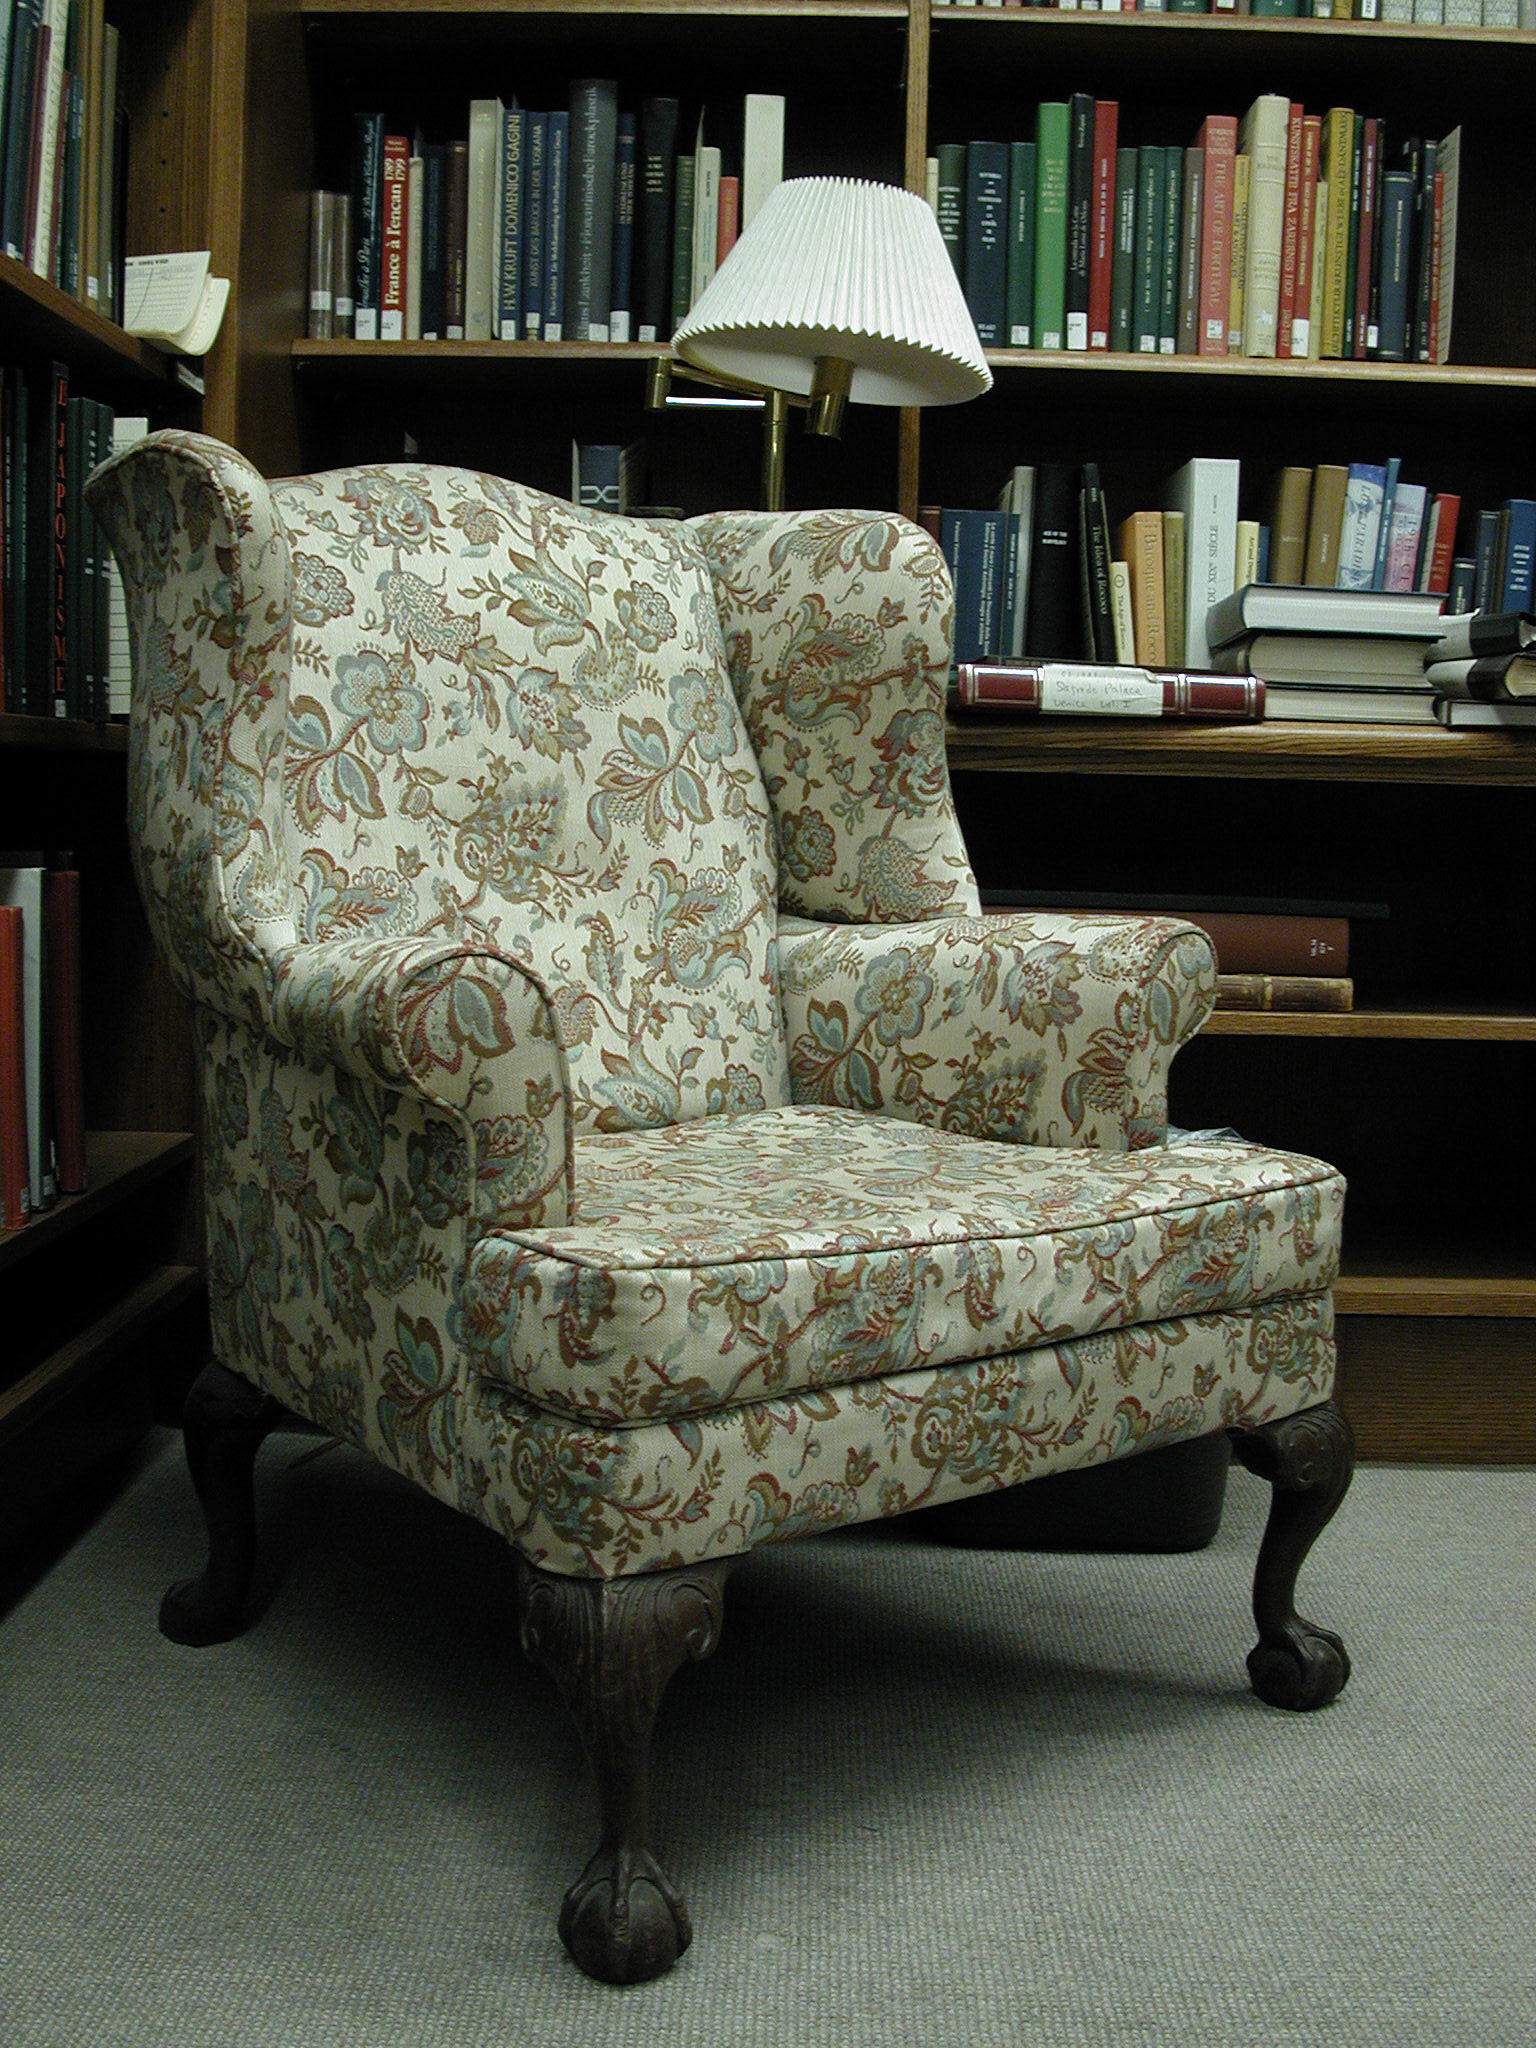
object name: wing chair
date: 1750-1760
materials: wood